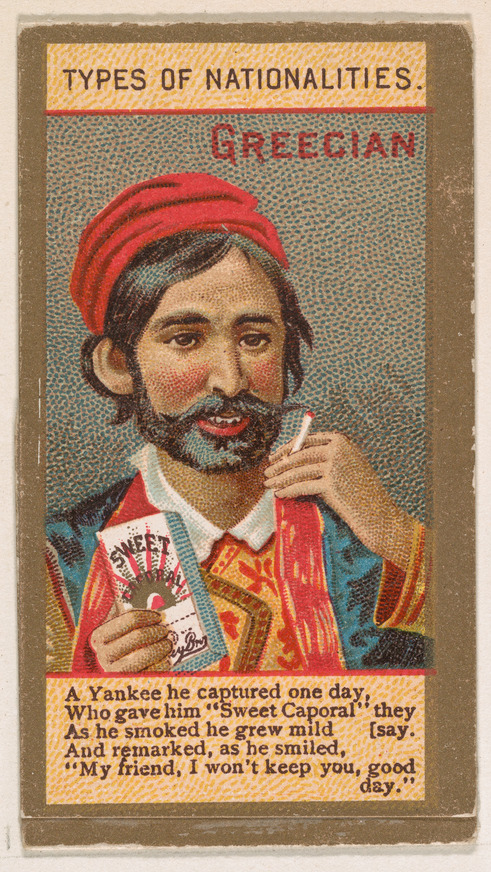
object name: print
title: Greecian, from Types of Nationalities (N240) issued by Kinney Bros.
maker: kinney brothers tobacco company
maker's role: publisher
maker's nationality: american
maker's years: 1869-2011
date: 1890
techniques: color lithograph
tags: men,smoking